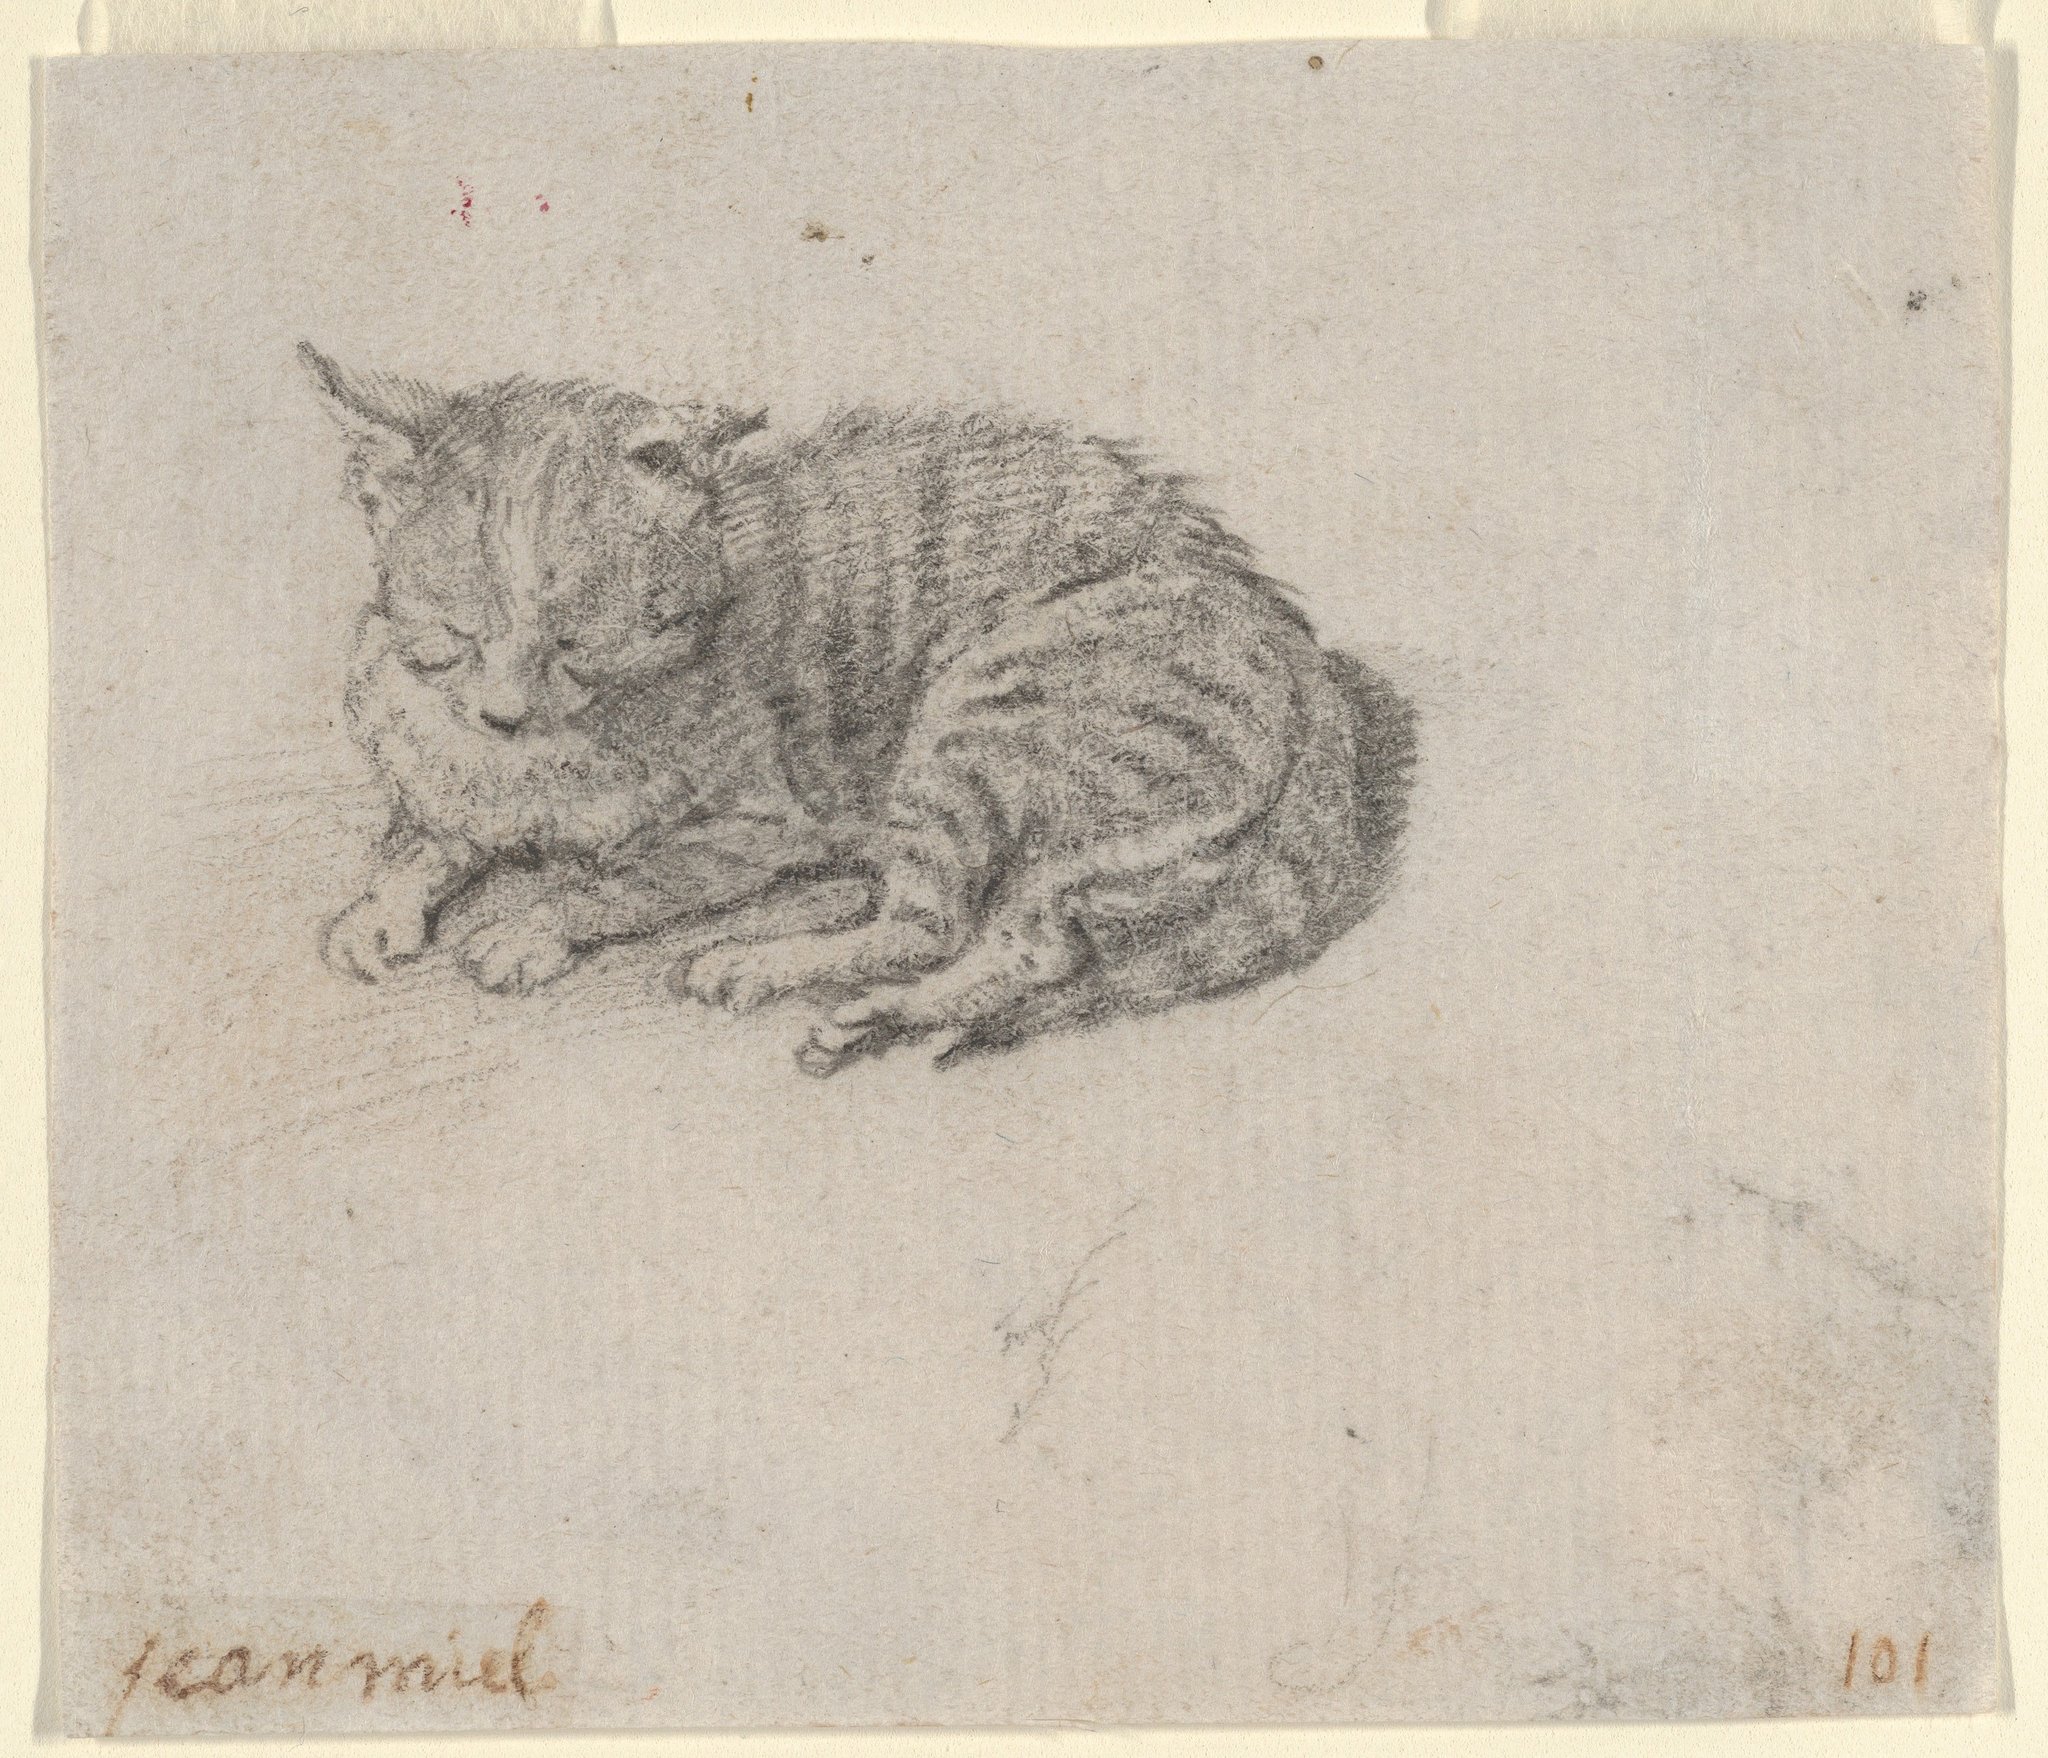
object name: drawing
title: Study of a Sleeping Cat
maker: jan miel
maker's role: artist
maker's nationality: flemish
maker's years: 1599-1664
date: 1634-1666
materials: chalk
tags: sleeping,cats